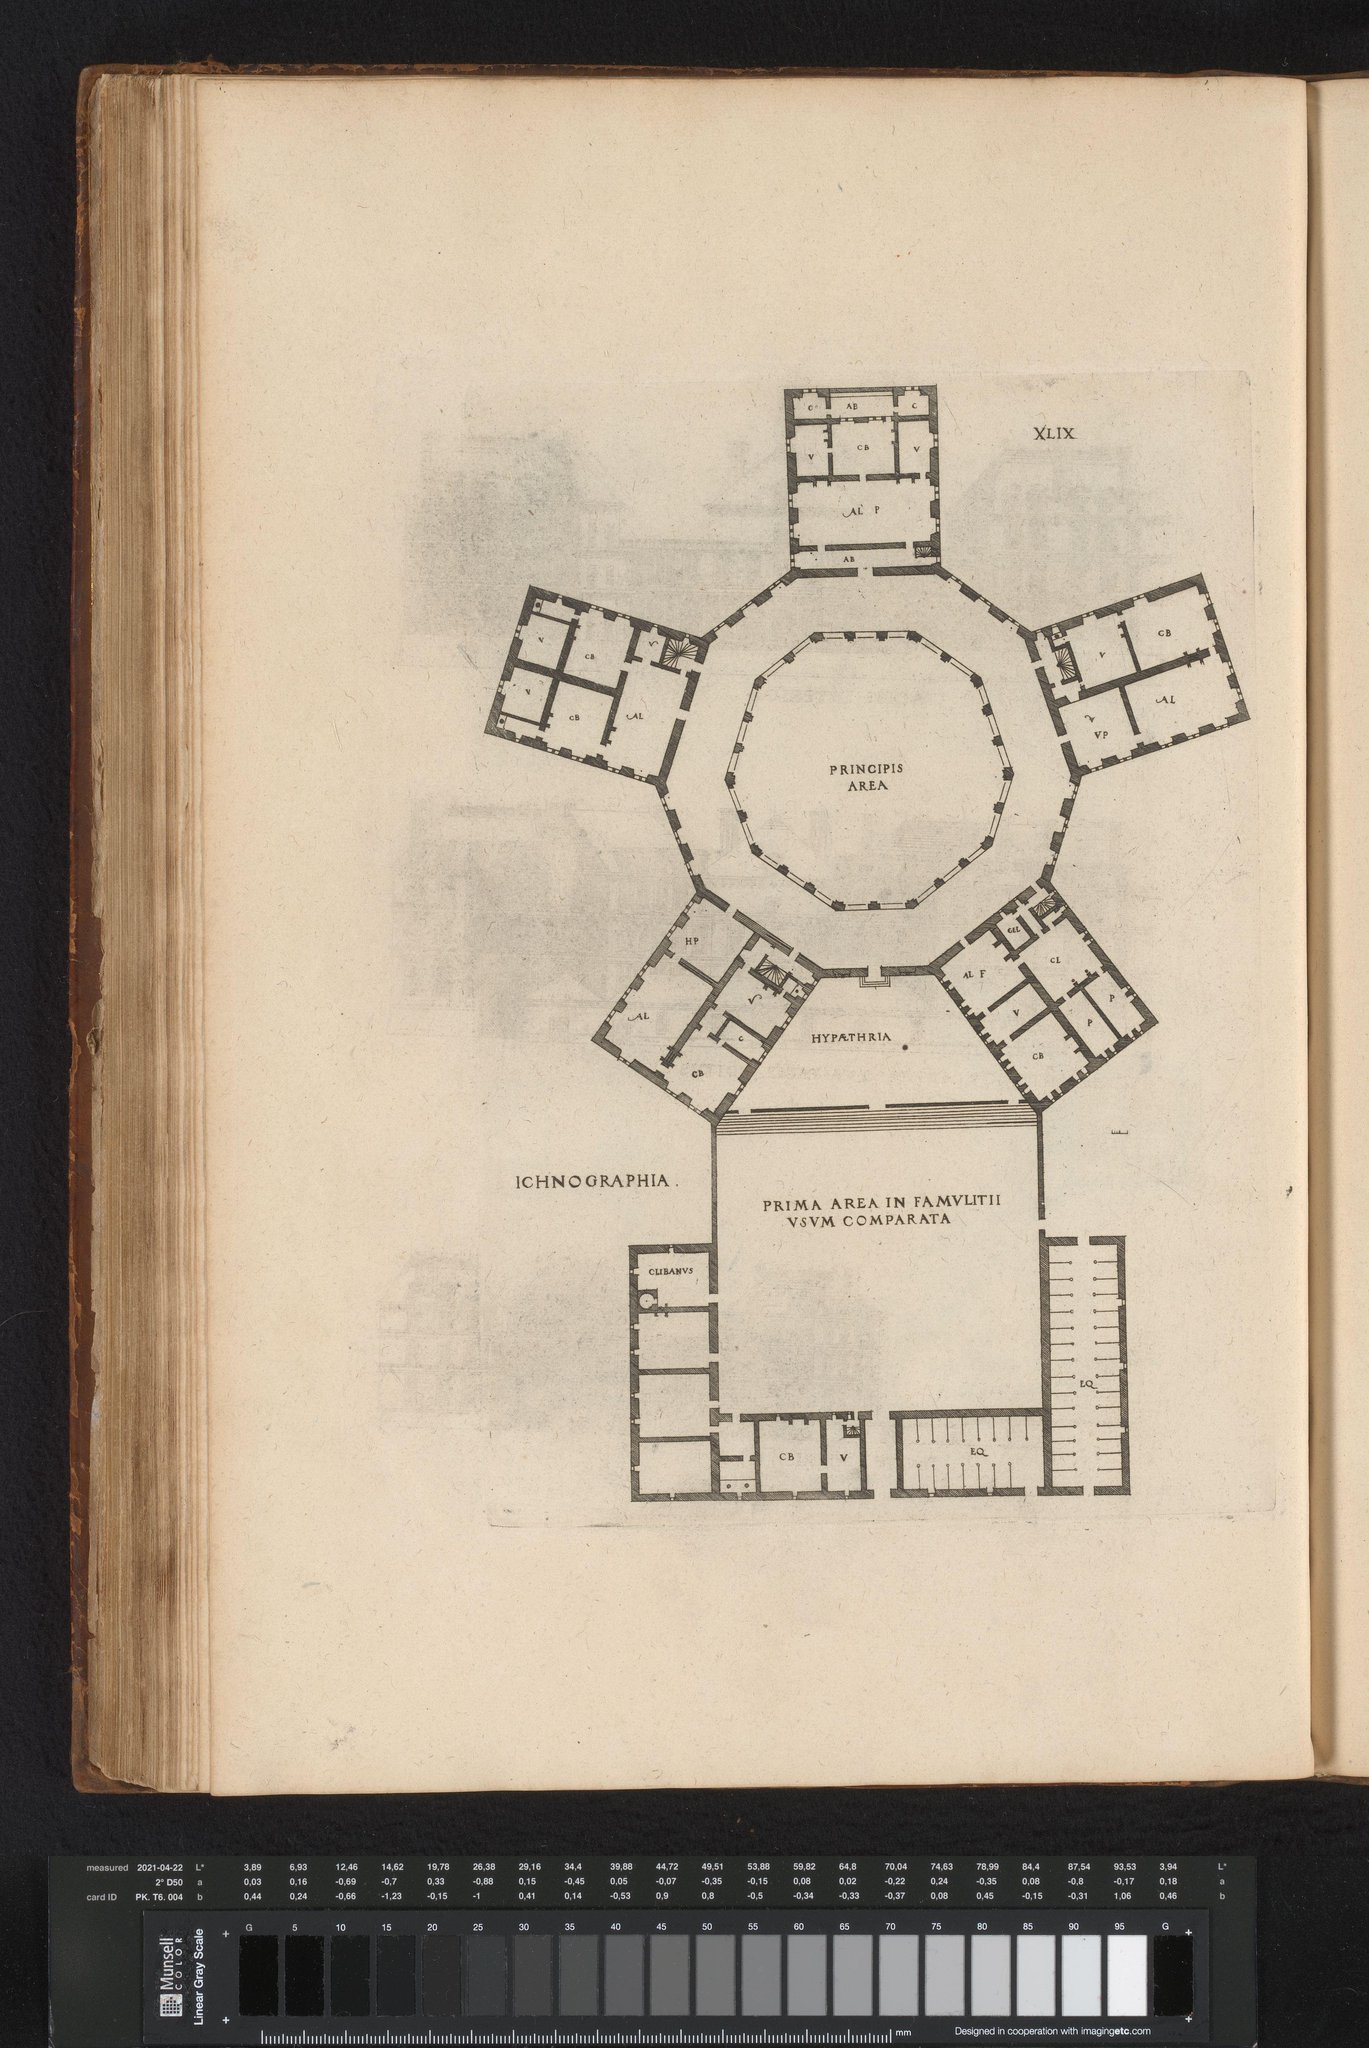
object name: ornament print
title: Plattegrond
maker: jacques androuet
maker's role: draughtsman, print maker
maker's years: 1515-1584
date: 1559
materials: paper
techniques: etching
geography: paris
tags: plan ~ architecture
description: Plattegrond van architectuur. Genummerd: XLIX. Onderdeel van 'De architectura Iacobi Androuetii du Cerceau' (1559): 69 etsen met 171 voorstellingen van architectuur en ornamentiek.